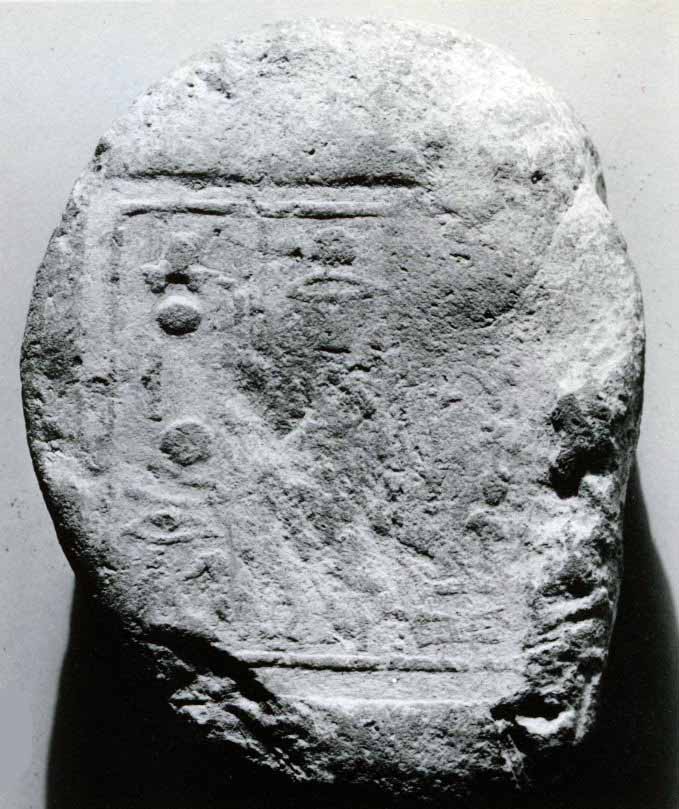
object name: cone, seniseneb, square impression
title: Funerary Cone of Overseer of the Seal Senneferi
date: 1550-1295 BCE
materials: pottery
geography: egypt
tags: hieroglyphs